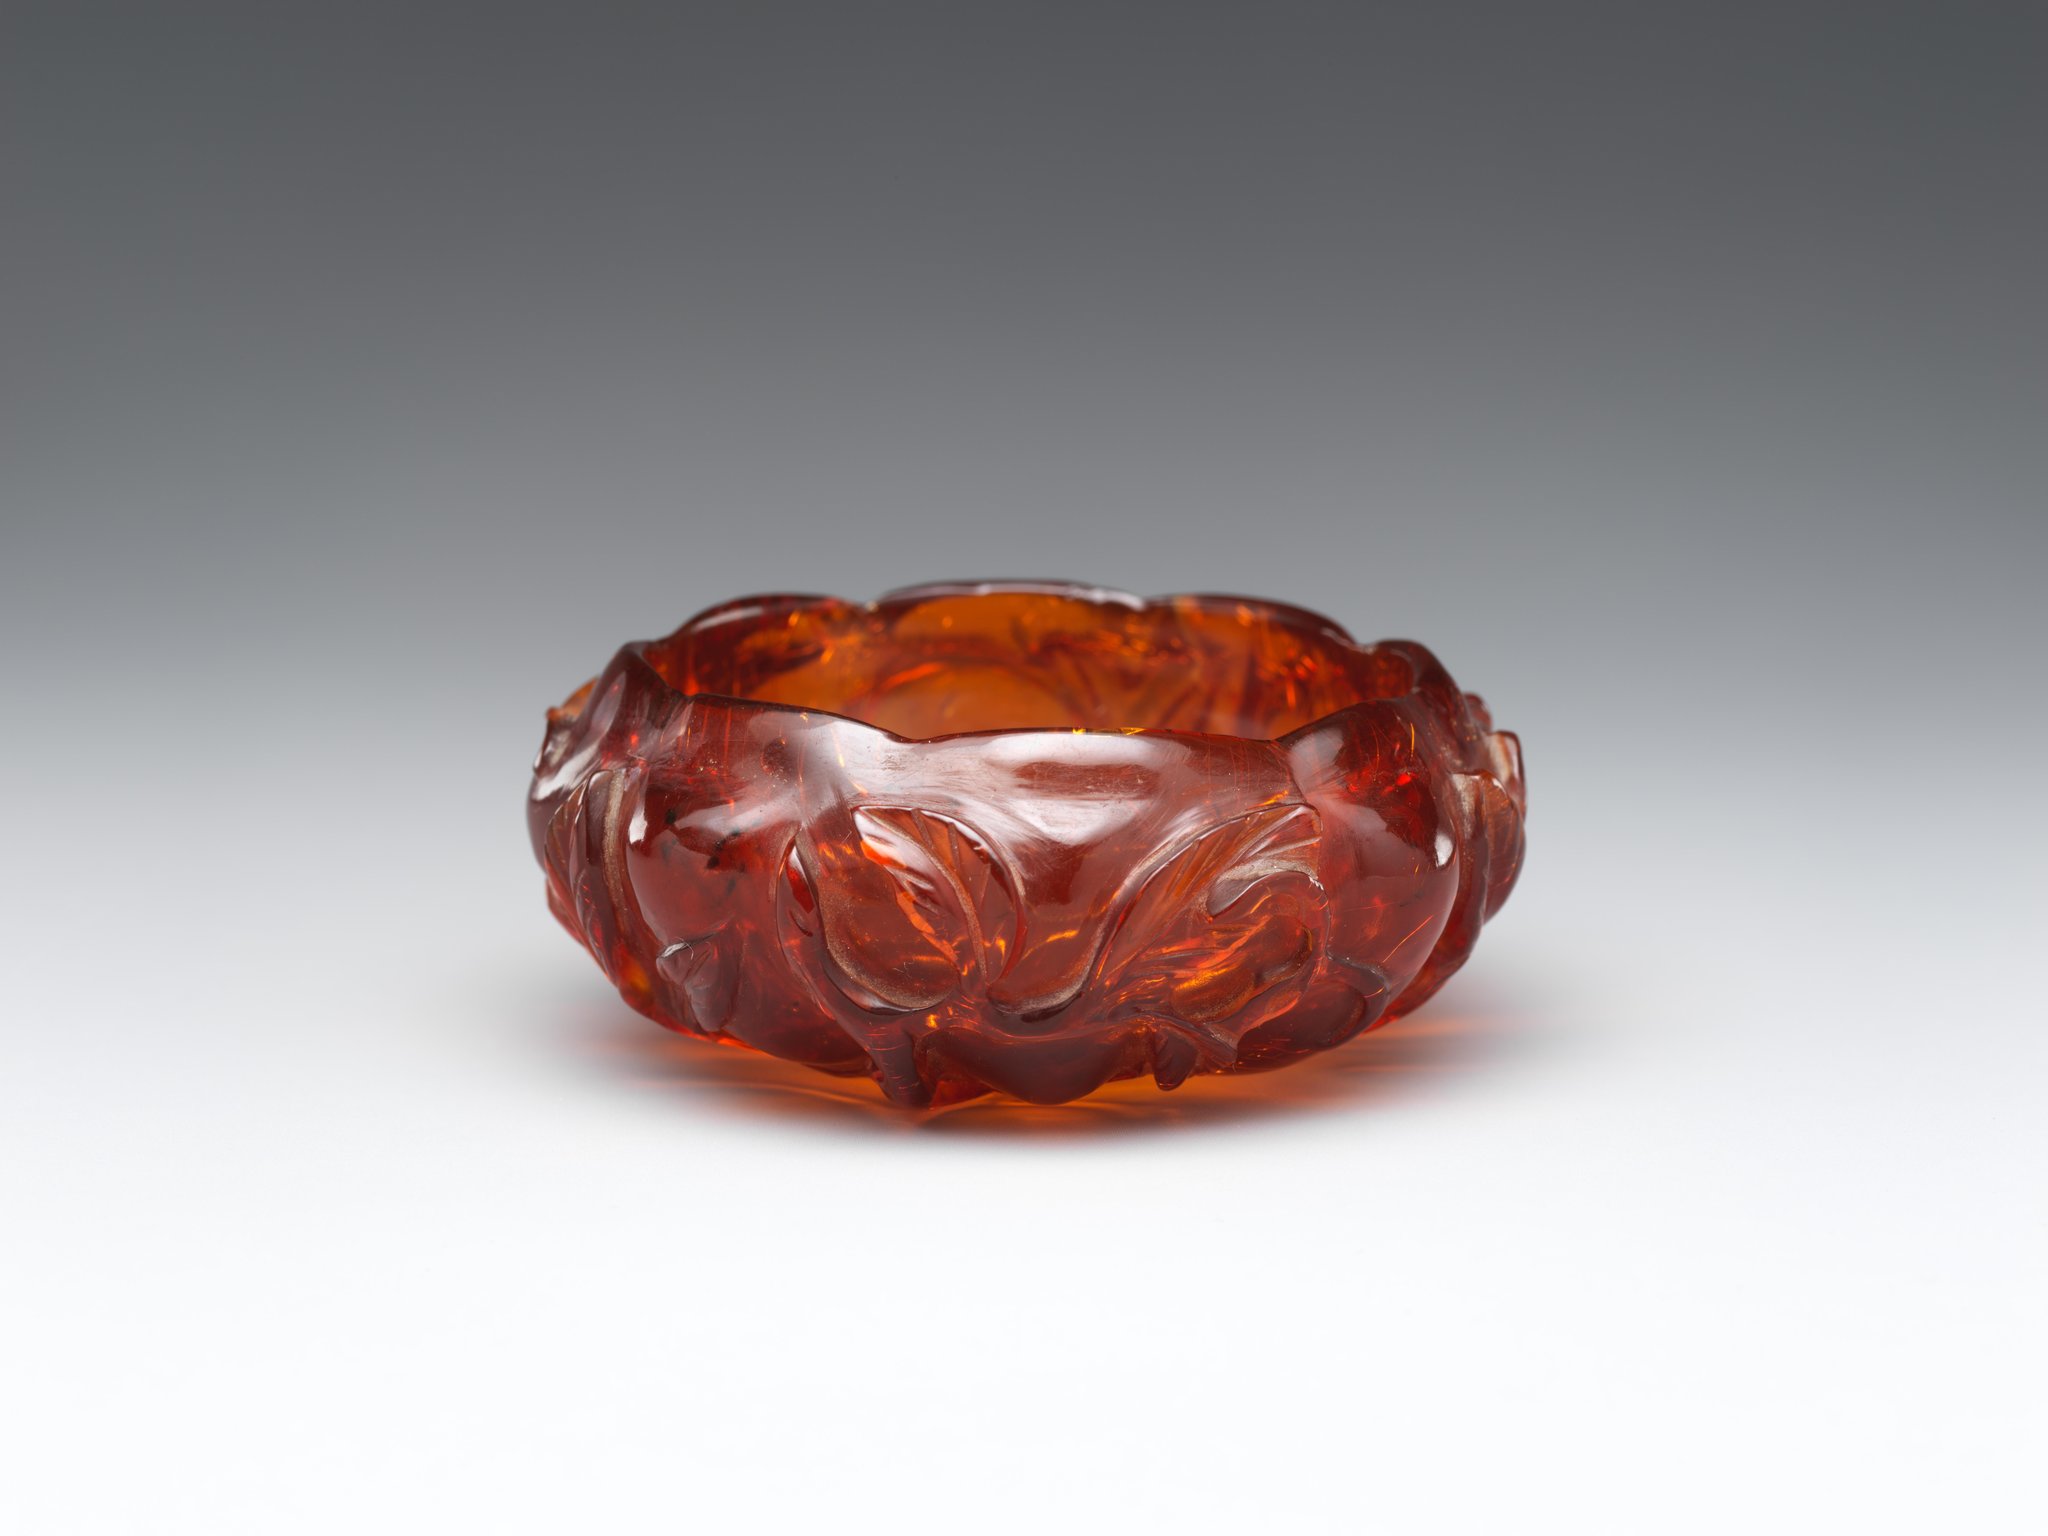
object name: bowl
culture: chinese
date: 1736-1795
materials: amber